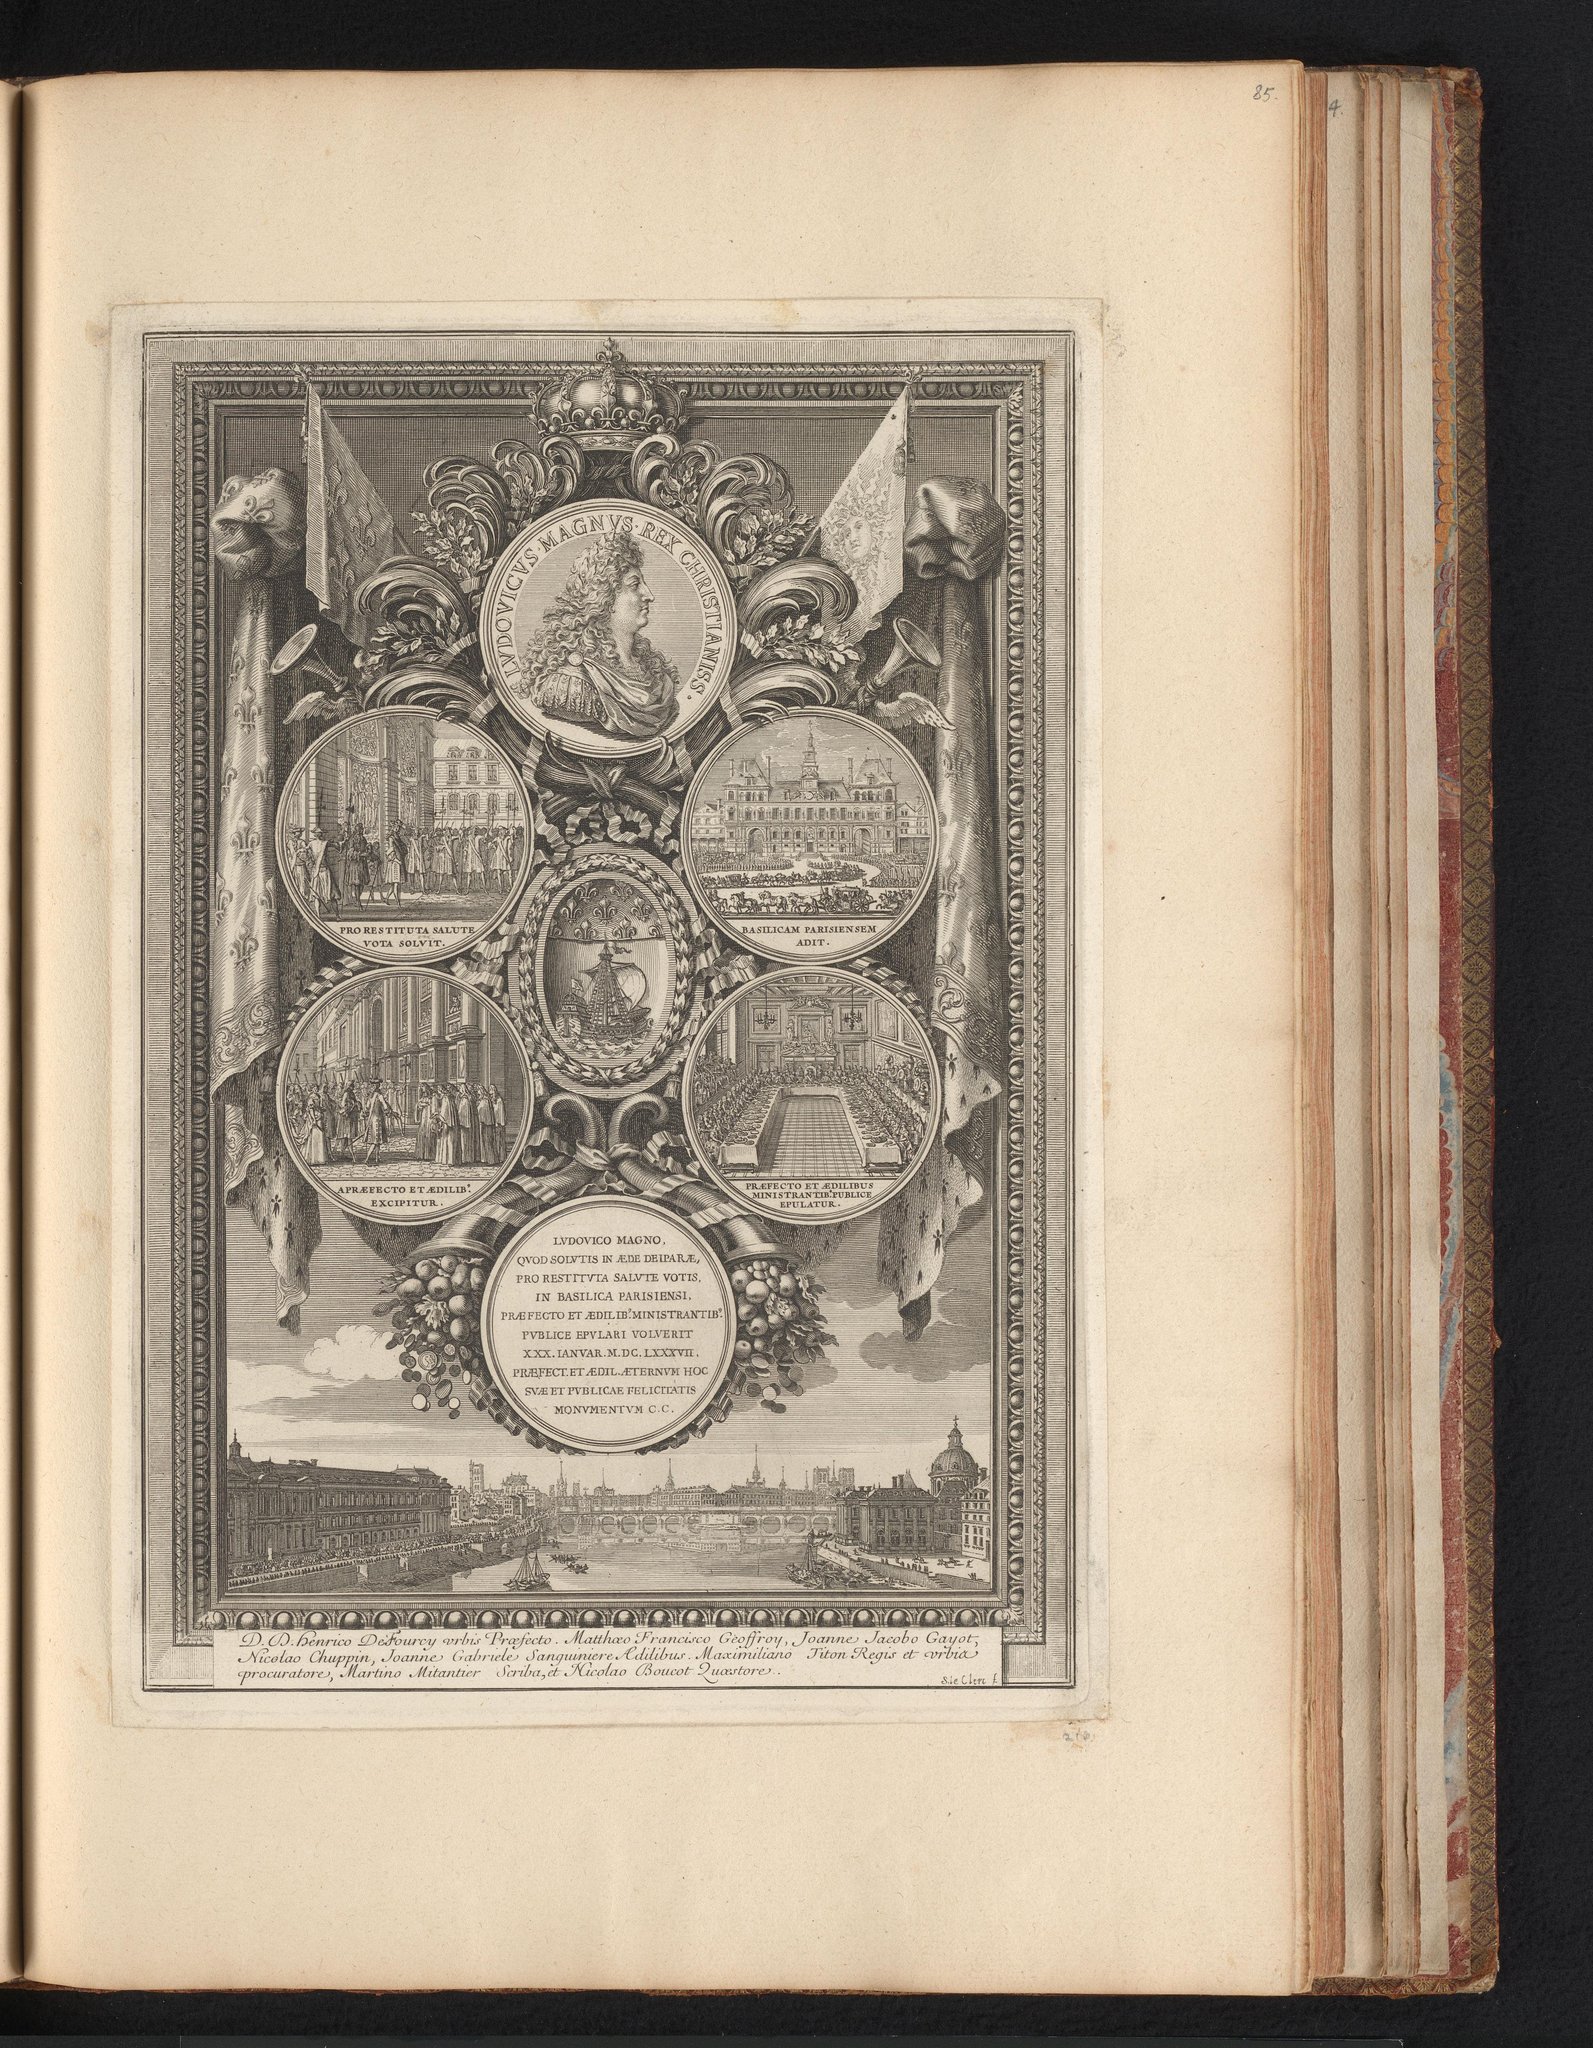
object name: album leaf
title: Ludovicus Magnus Rex Christianiss.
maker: sébastien leclerc (i)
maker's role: print maker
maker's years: 1637-1714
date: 1687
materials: paper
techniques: engraving, etching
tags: lodewijk xiv (koning van frankrijk), reception, cocktail party, historical persons, king, recovery, convalescence of sick person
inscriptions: date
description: Receptie van de koning in het Hôtel de Ville ter gelegenheid van zijn genezing na een ziekte. Prent maakt deel uit van een album.